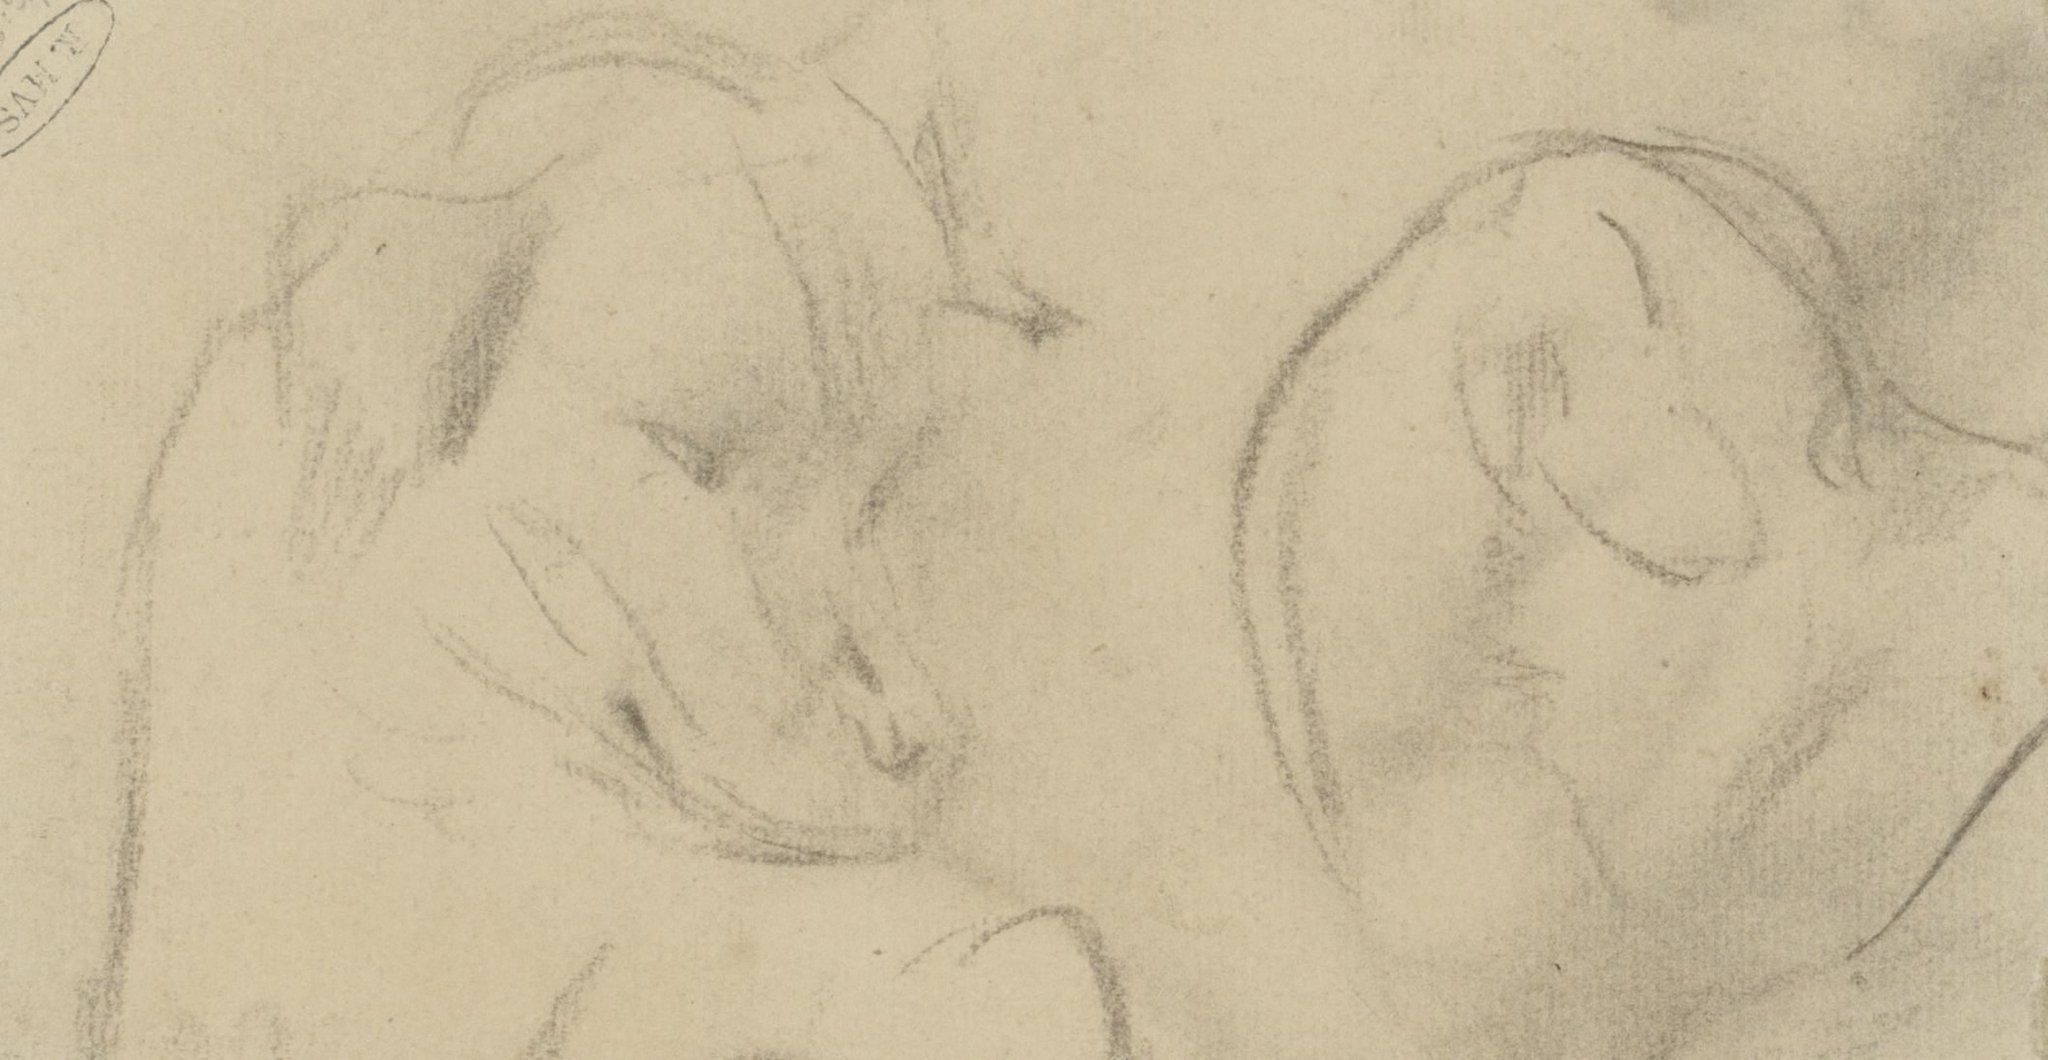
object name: drawing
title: Twee hondenkoppen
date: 1880-1923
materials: chalk, paper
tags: dog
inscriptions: collector's mark: Lugt 2228